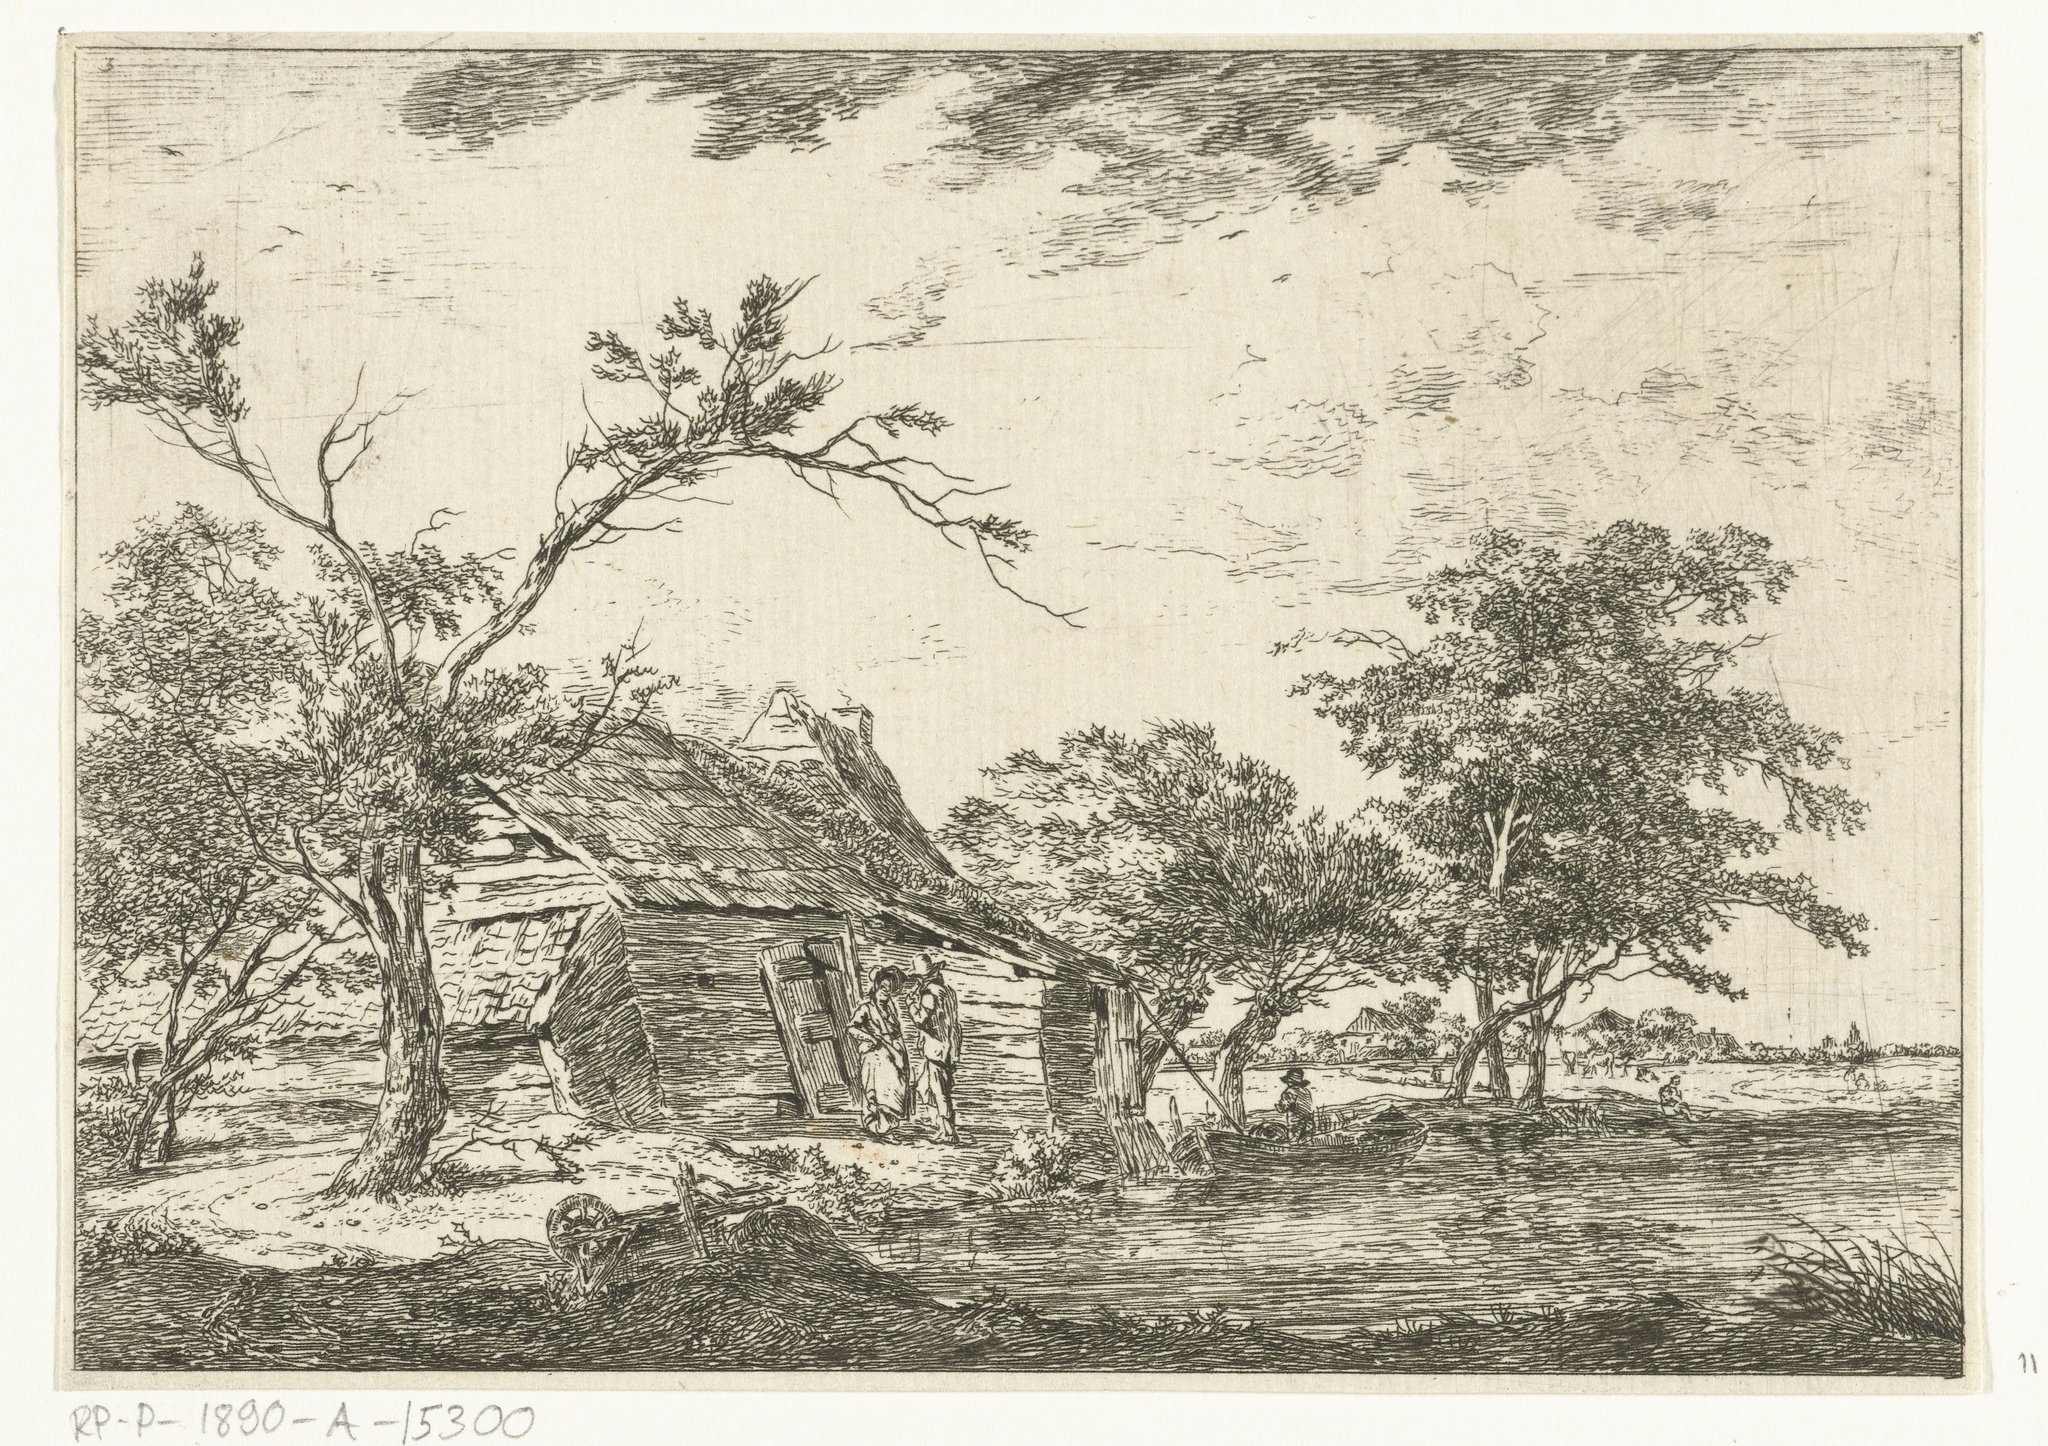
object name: print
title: Pratend stel bij boerderij aan waterkant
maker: hermanus van brussel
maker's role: draughtsman, print maker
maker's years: 1763-1815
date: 1800-1815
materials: paper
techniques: etching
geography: netherlands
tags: landscapes in the temperate zone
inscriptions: collector's mark: Lugt 2228